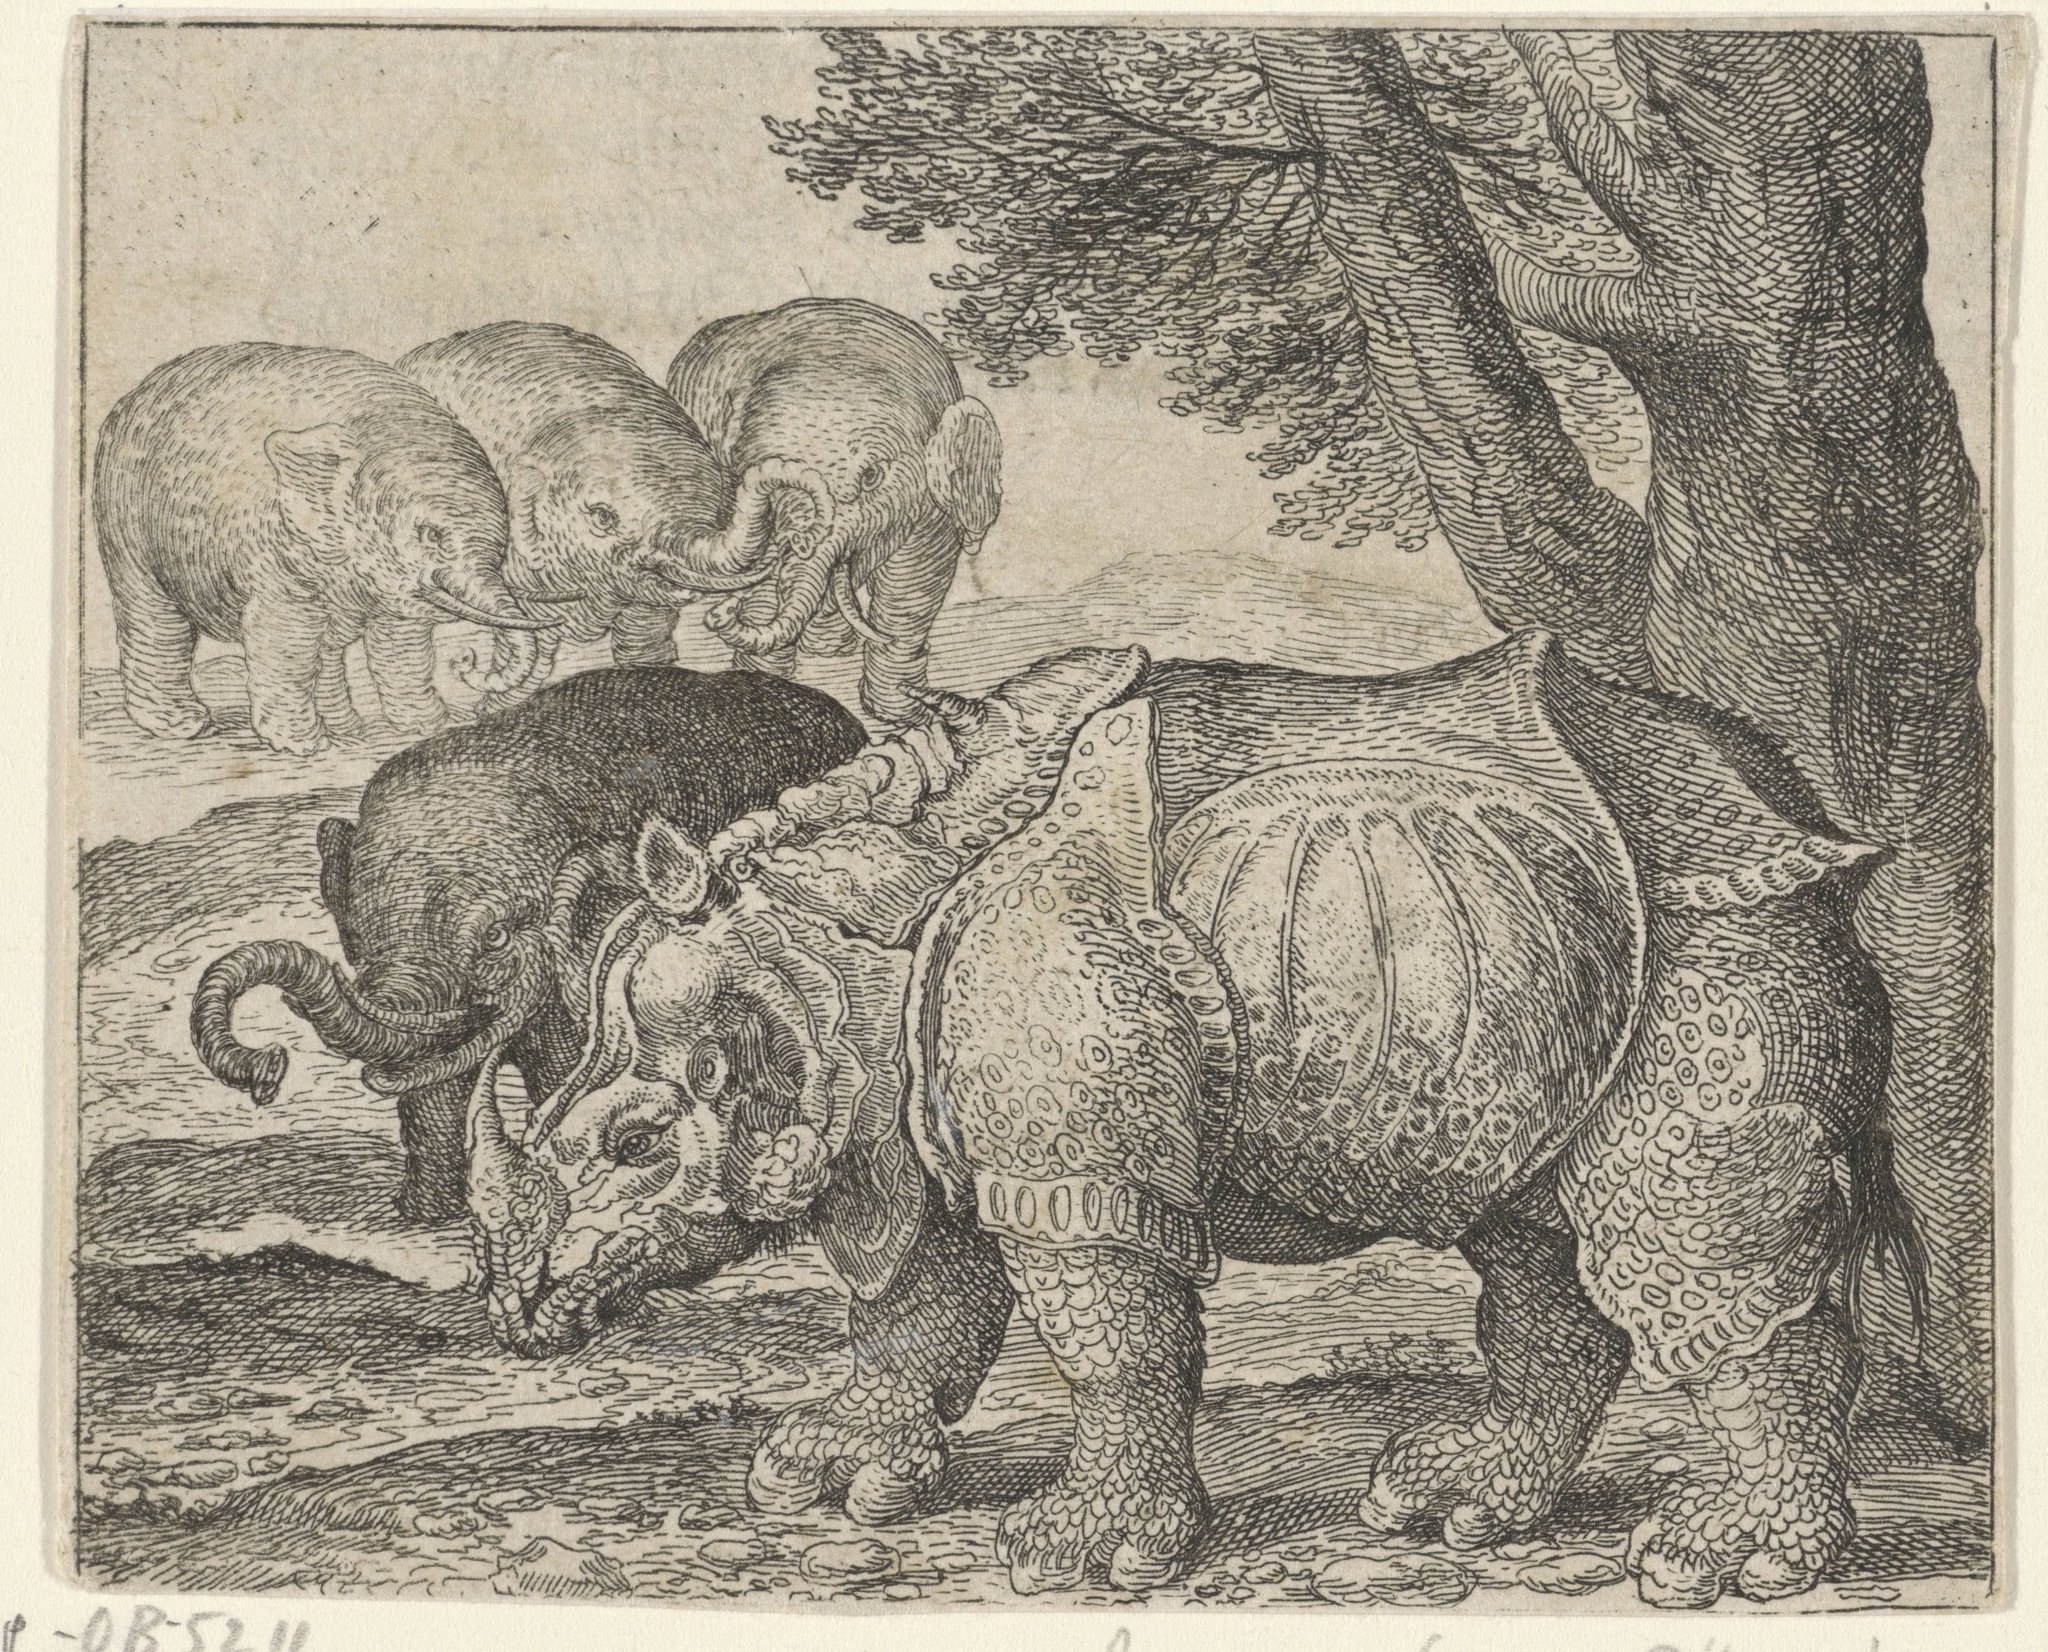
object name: book illustration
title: Fabel van de neushoorn en de olifanten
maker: aegidius sadeler (ii)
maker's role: draughtsman, print maker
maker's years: 1568-1629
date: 1608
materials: paper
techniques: engraving, etching, letterpress printing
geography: prague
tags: hoofed animals: rhinoceros, fables, trunked animals: elephant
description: Een neushoorn op de voorgrond. Vier olifanten op de achtergrond. De moraal van het verhaal leert dat je jezelf trouw moet blijven, zelf in moeilijke omstandigheden.